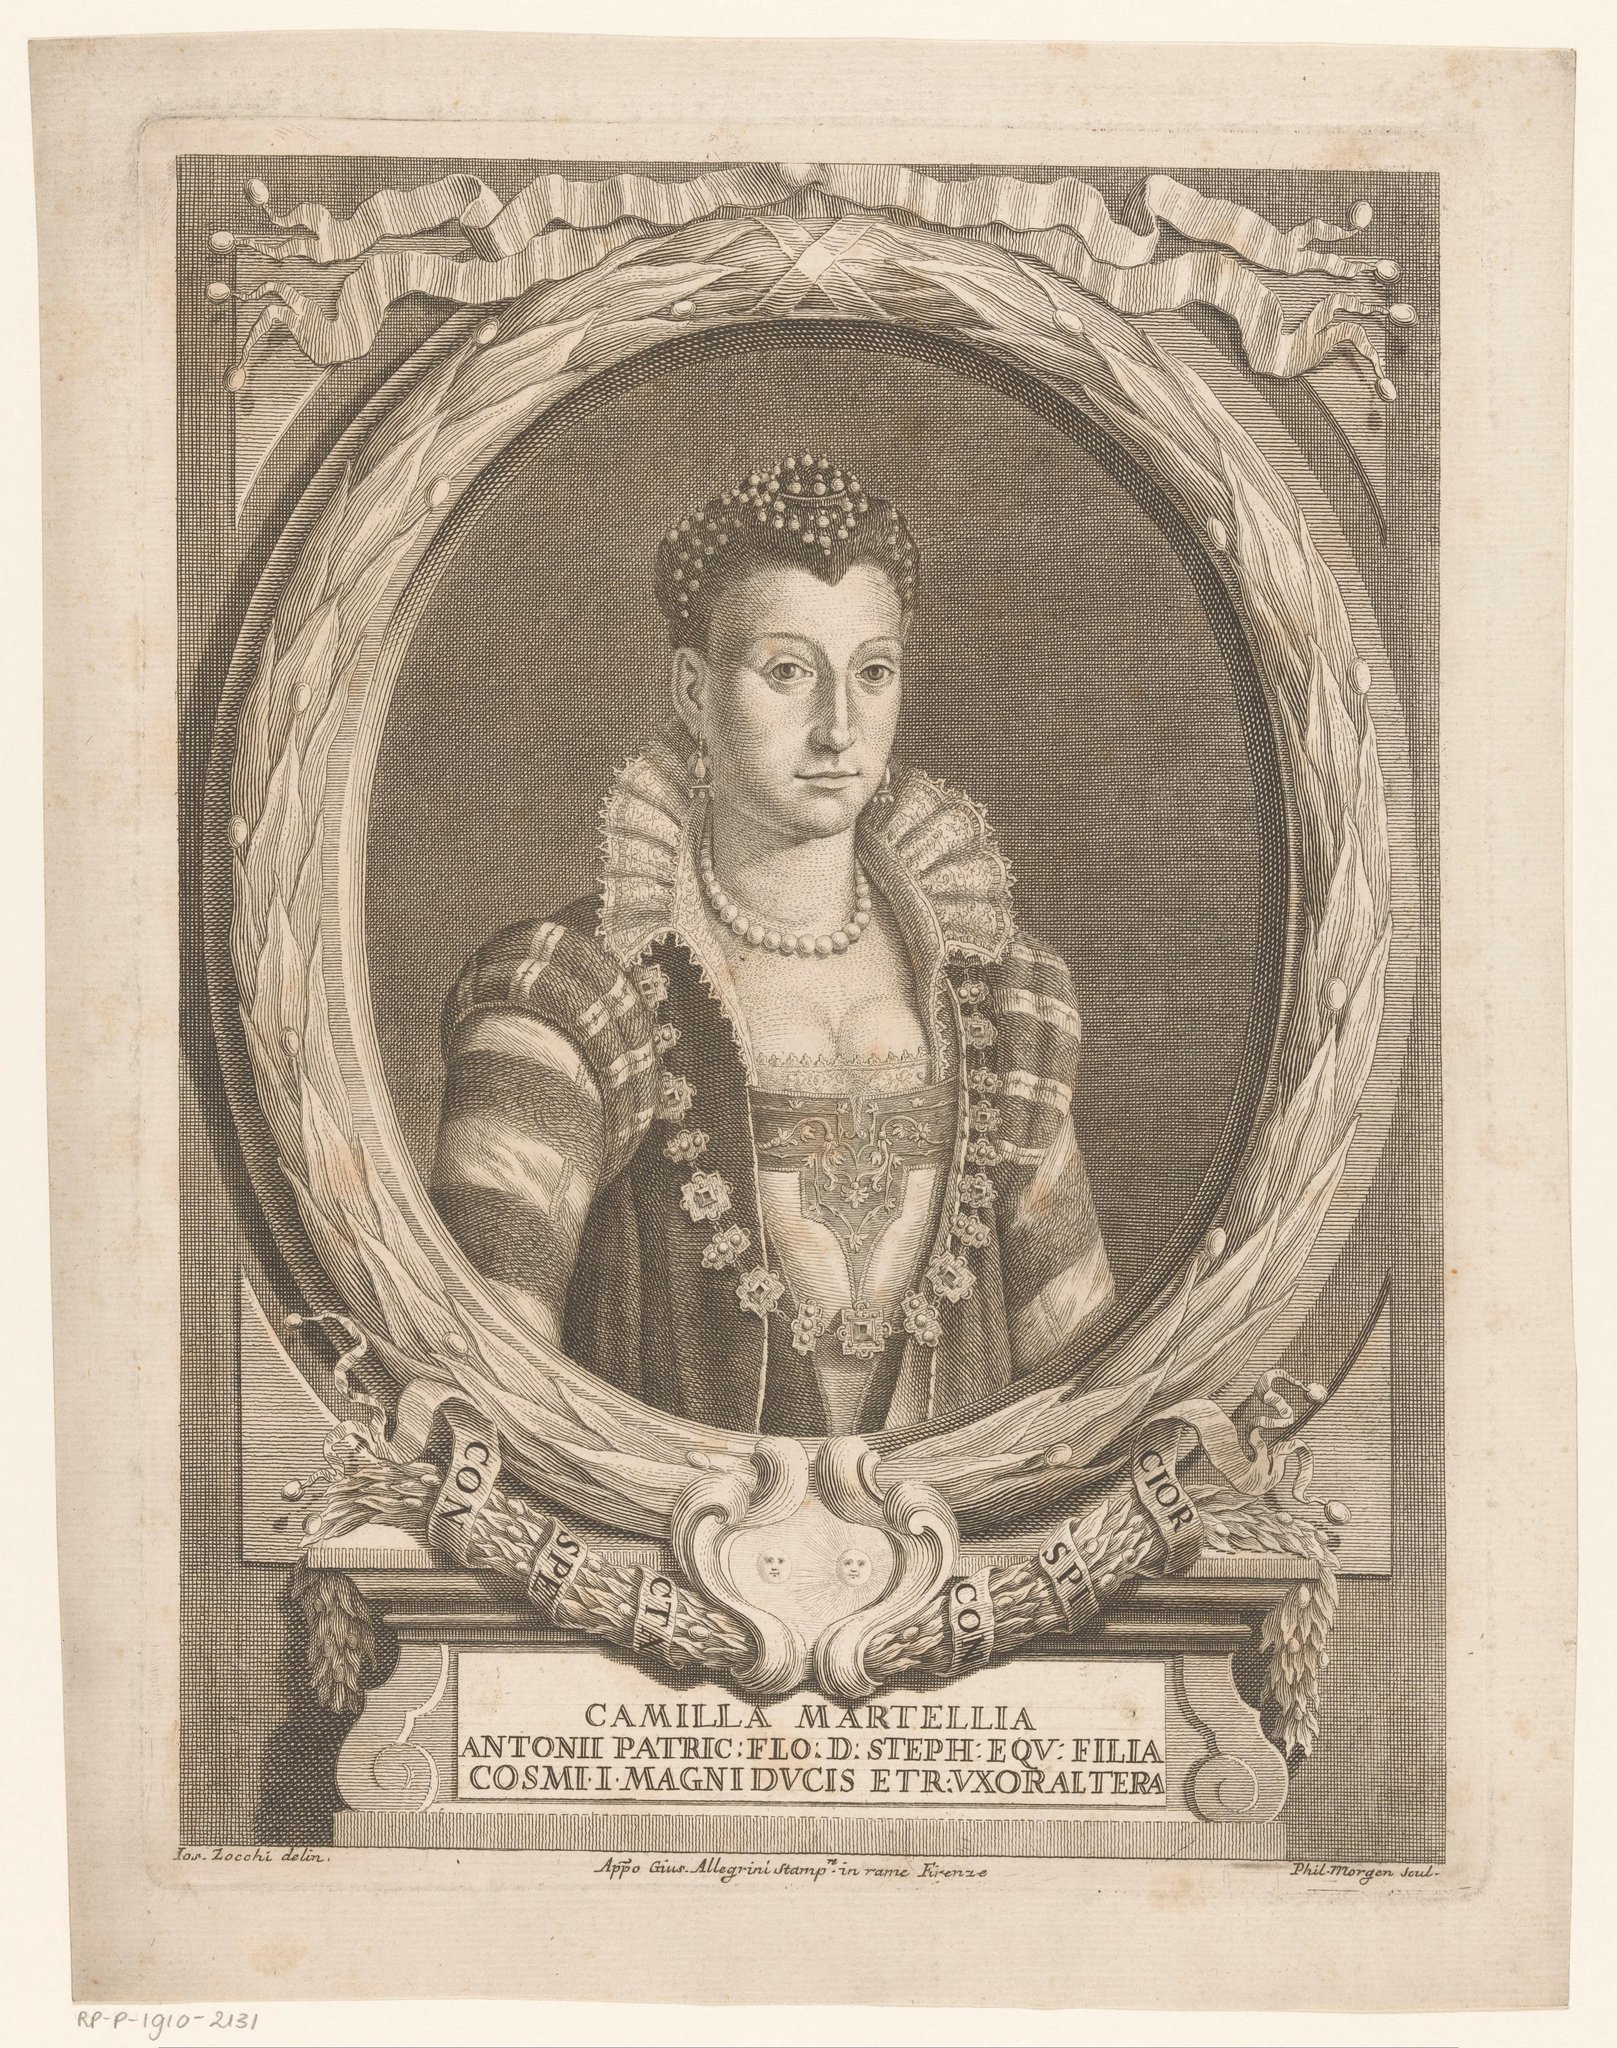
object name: print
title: Portret van Camilla Martelli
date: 1740-1807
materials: paper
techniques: engraving, etching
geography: italy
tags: historical persons, ruler, sovereign - bb - female ruler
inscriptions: collector's mark: Lugt 2228